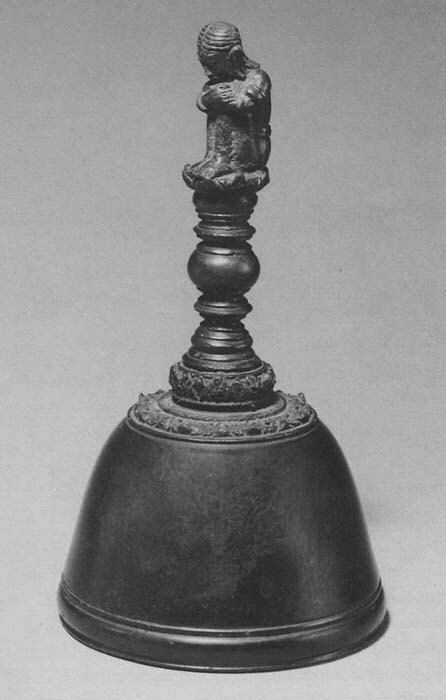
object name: bell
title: Hand Bell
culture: indonesian, javanese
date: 1201-1400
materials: bronze